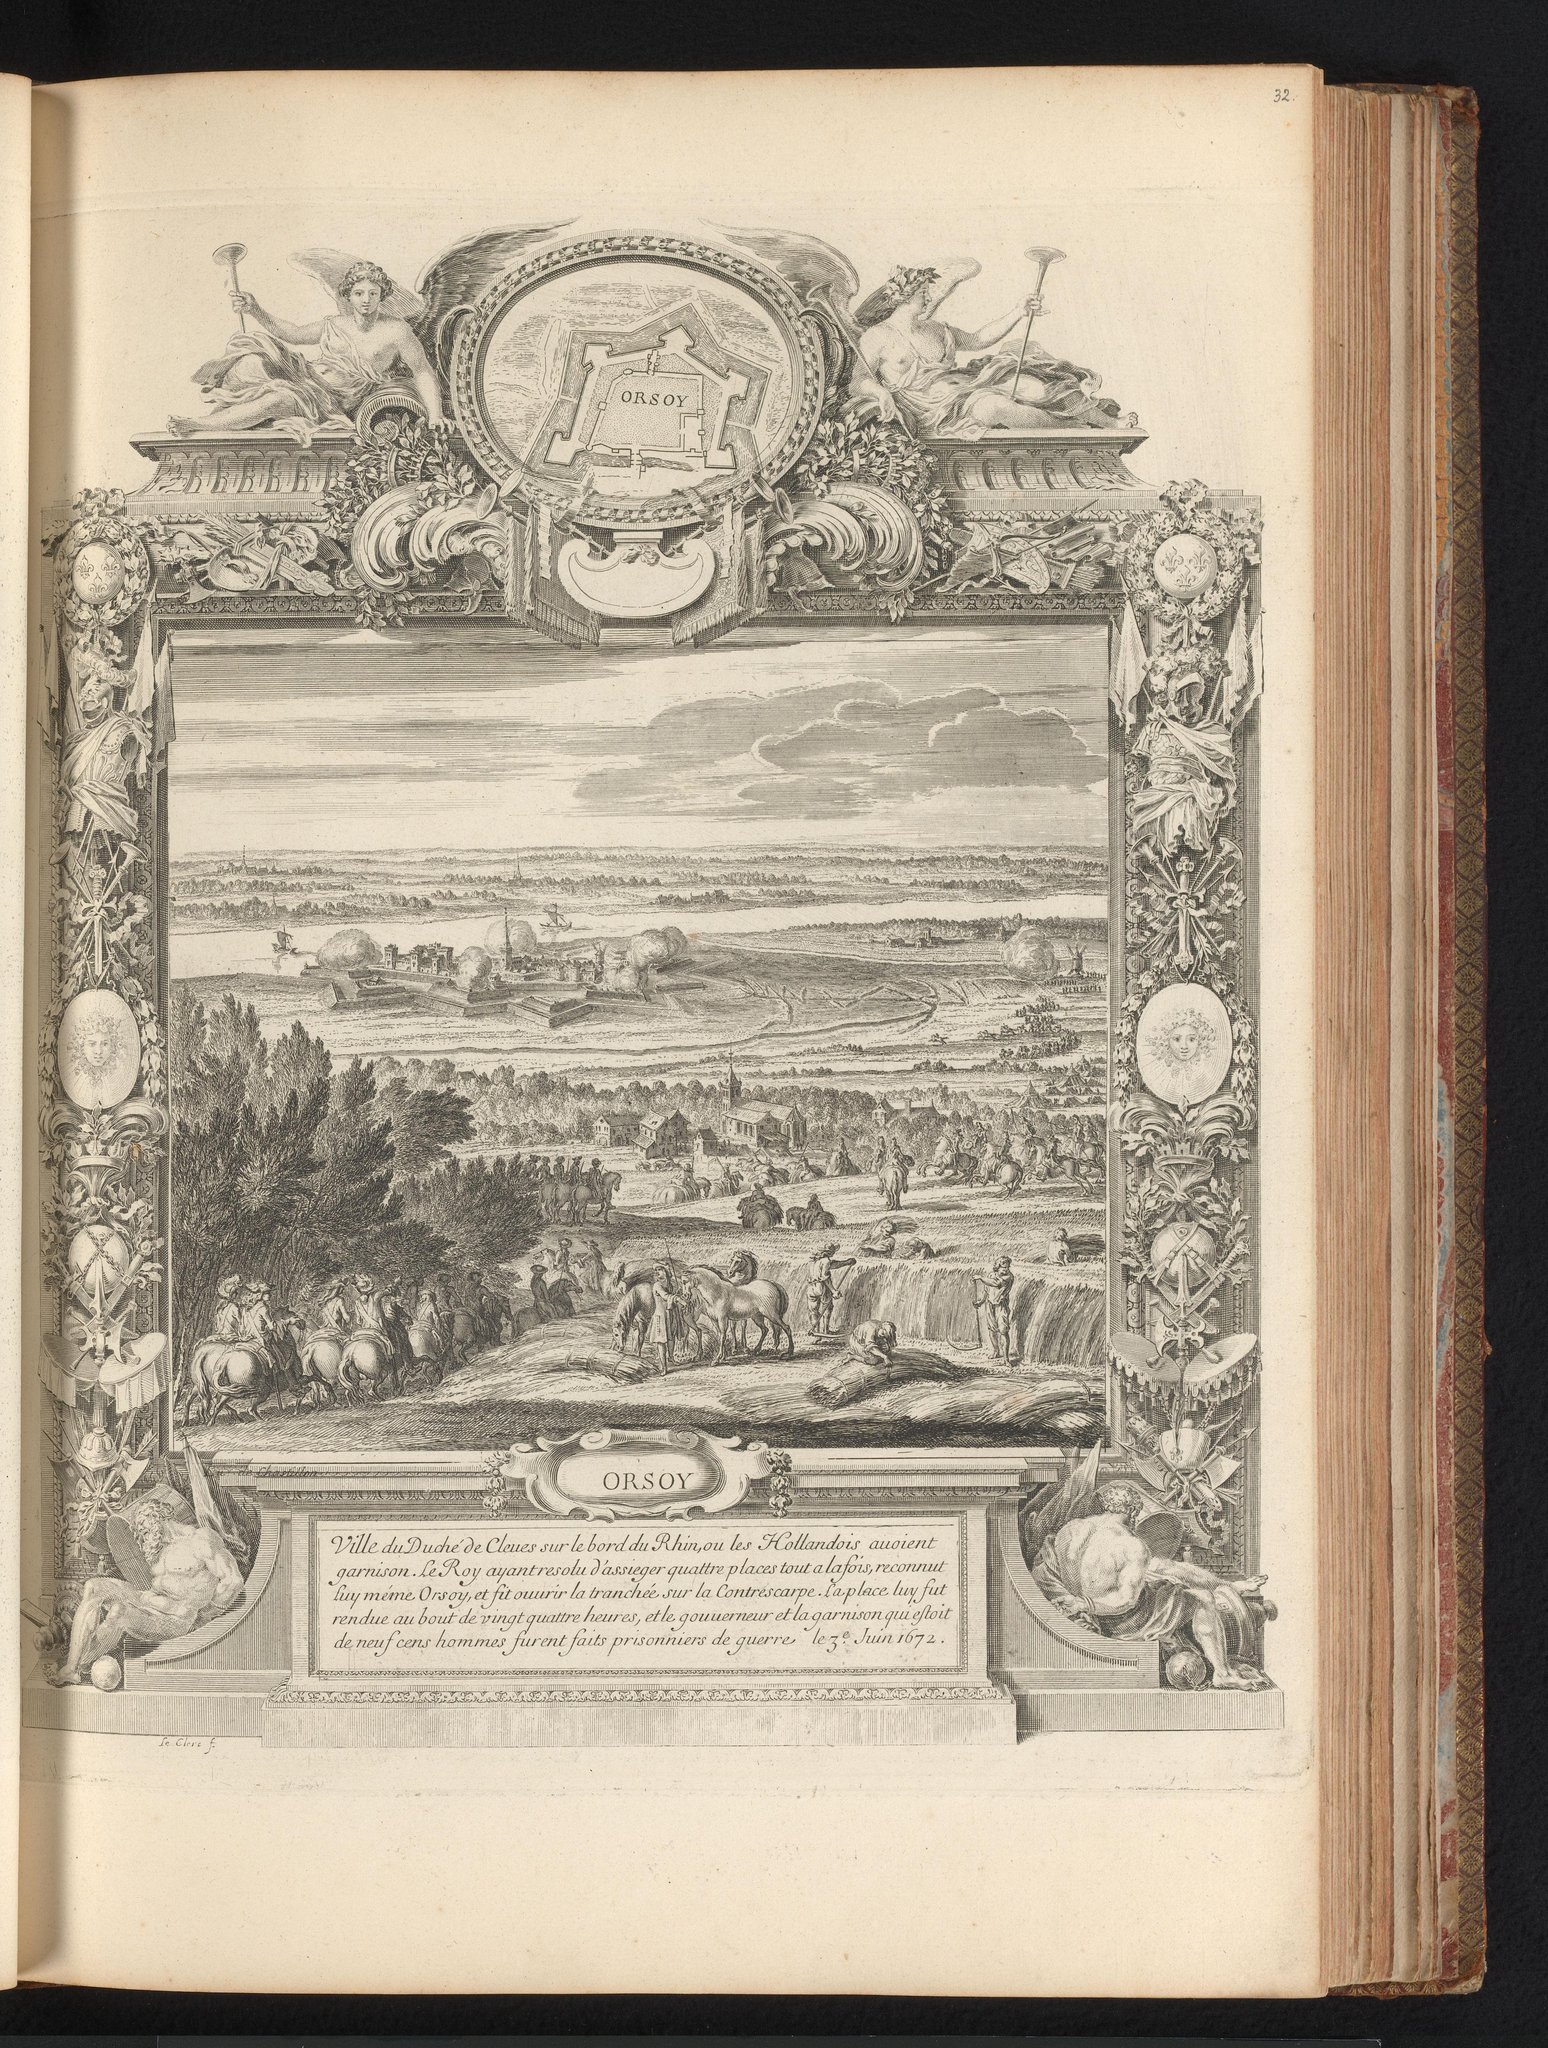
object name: album leaf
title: Grandes conquêtes du Roi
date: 1686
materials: paper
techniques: engraving, etching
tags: battle, siege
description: Maakt deel uit van een serie bestaande uit 28 prenten met oorlogstaferelen in ornamentele cartouches. De prenten zijn gedrukt van twee afzonderlijke platen bestaande uit de voorstelling en de cartouche.